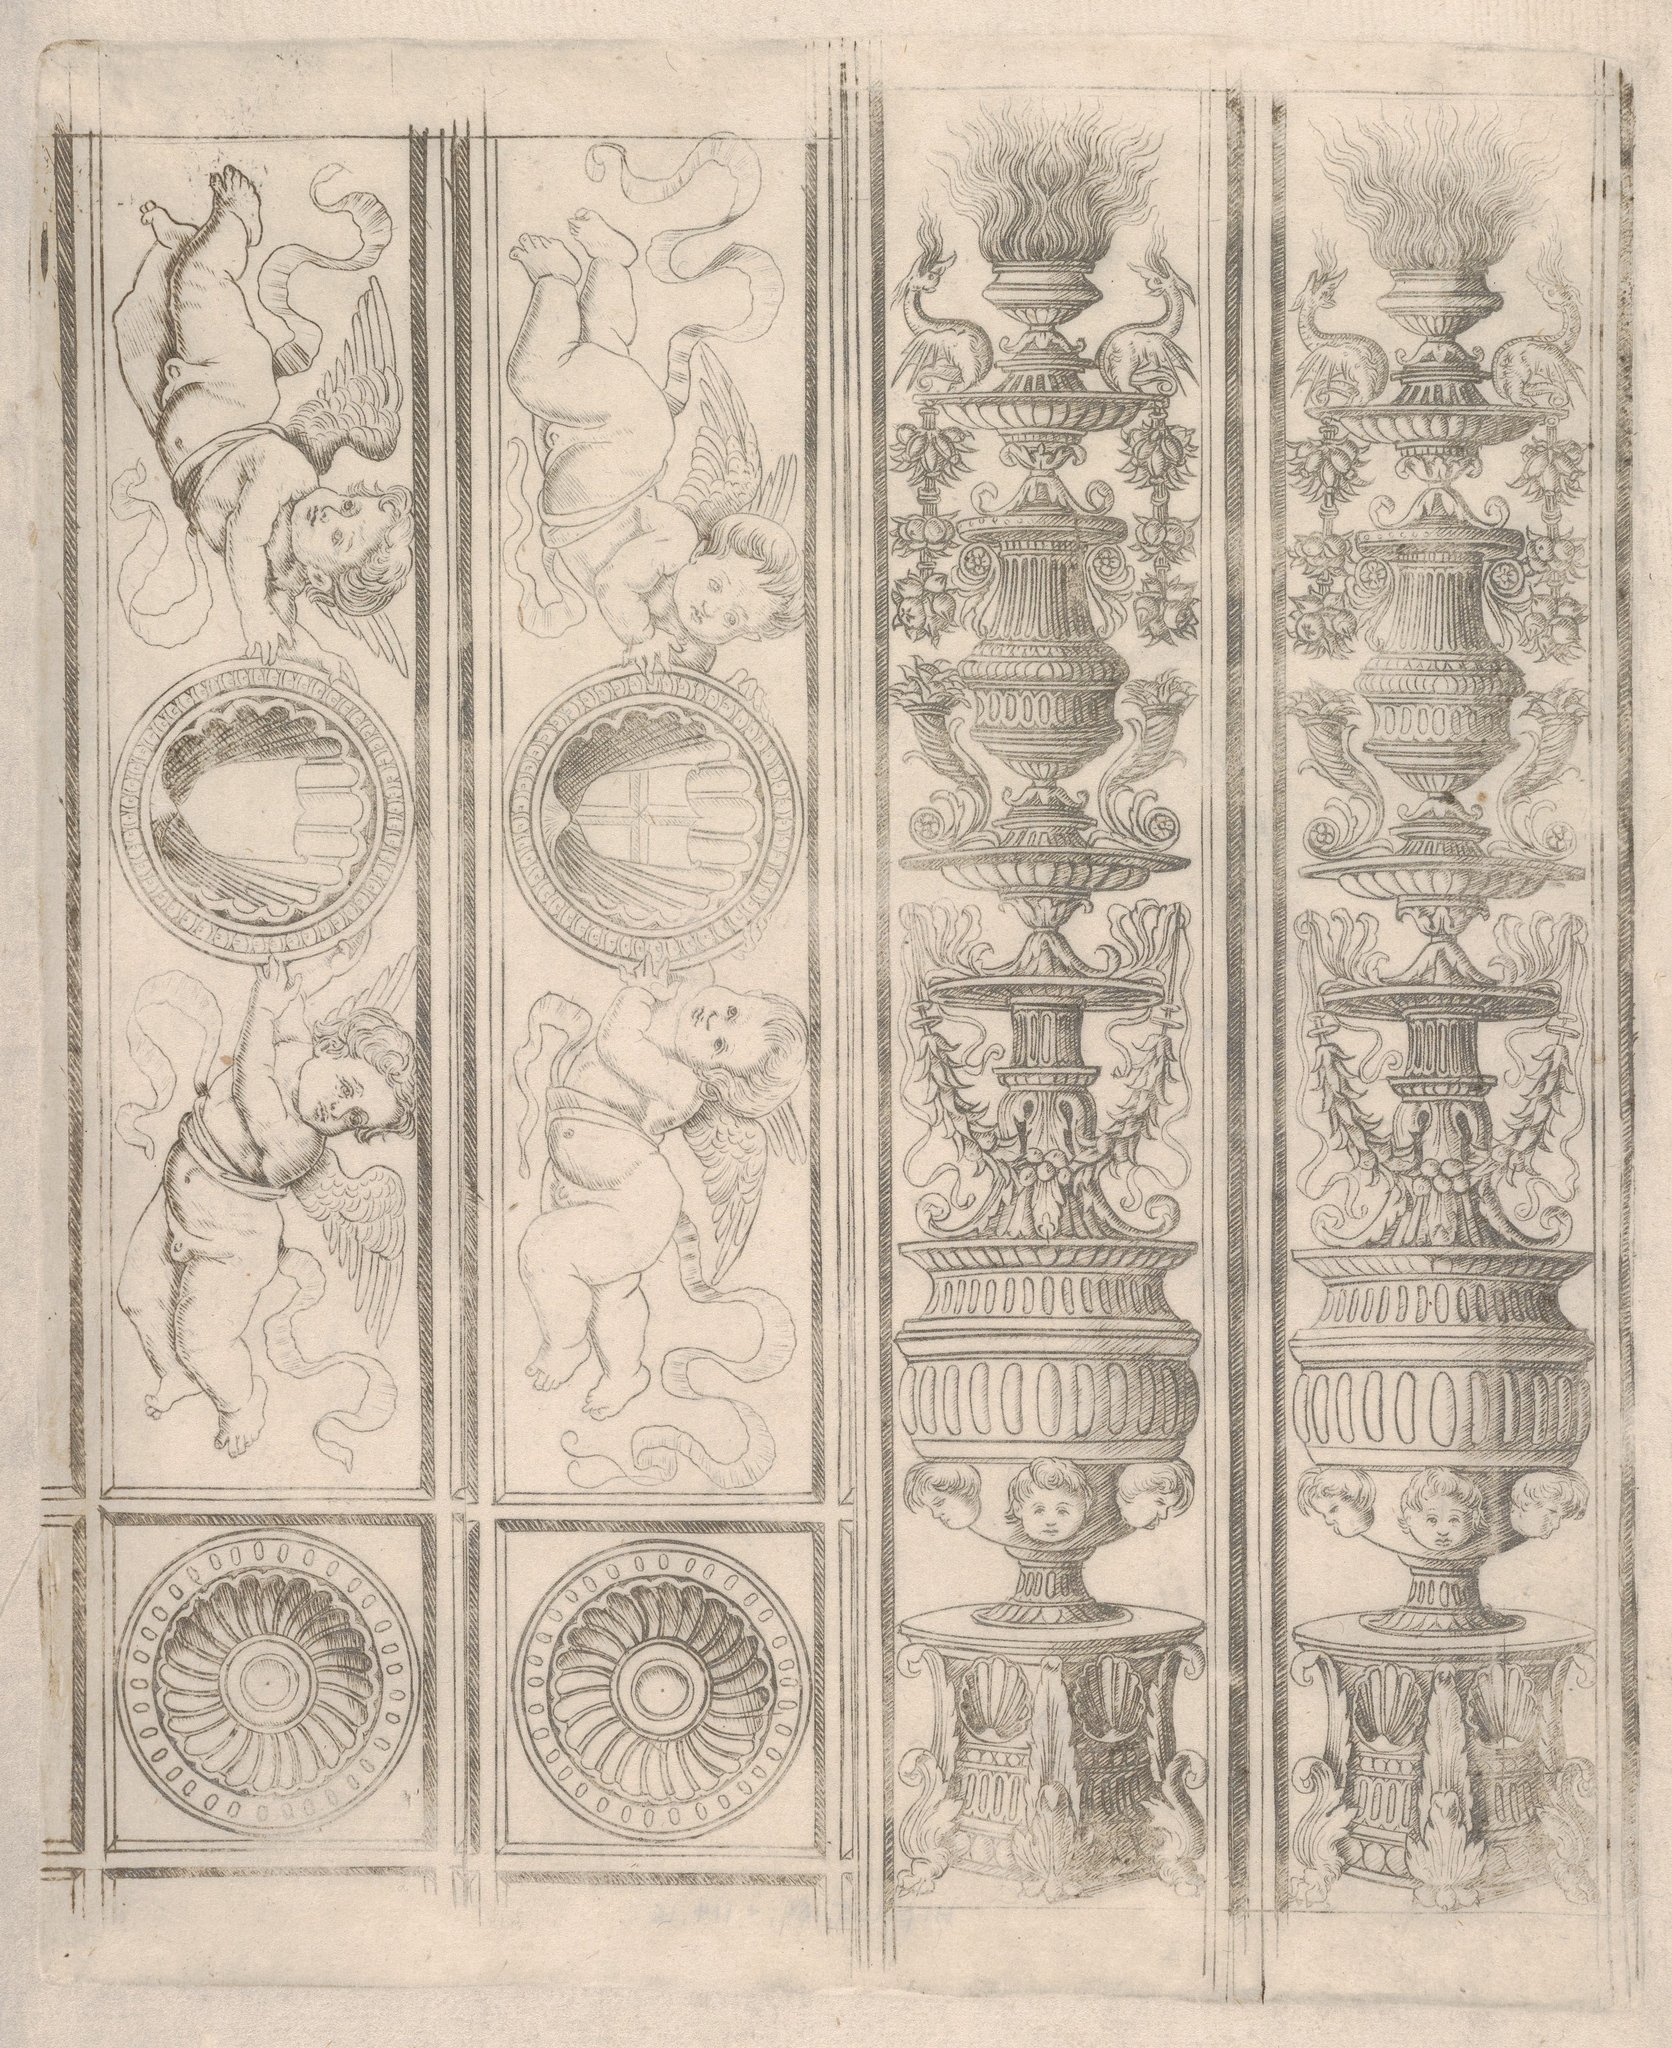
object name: print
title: Sheet of border segments: two candelabra and two horizontal pieces with putti, two corners, from Life of the Virgin and Christ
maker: francesco rosselli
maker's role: artist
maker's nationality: italian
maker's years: 1448-1527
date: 1490-1500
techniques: engraving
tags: candelabra